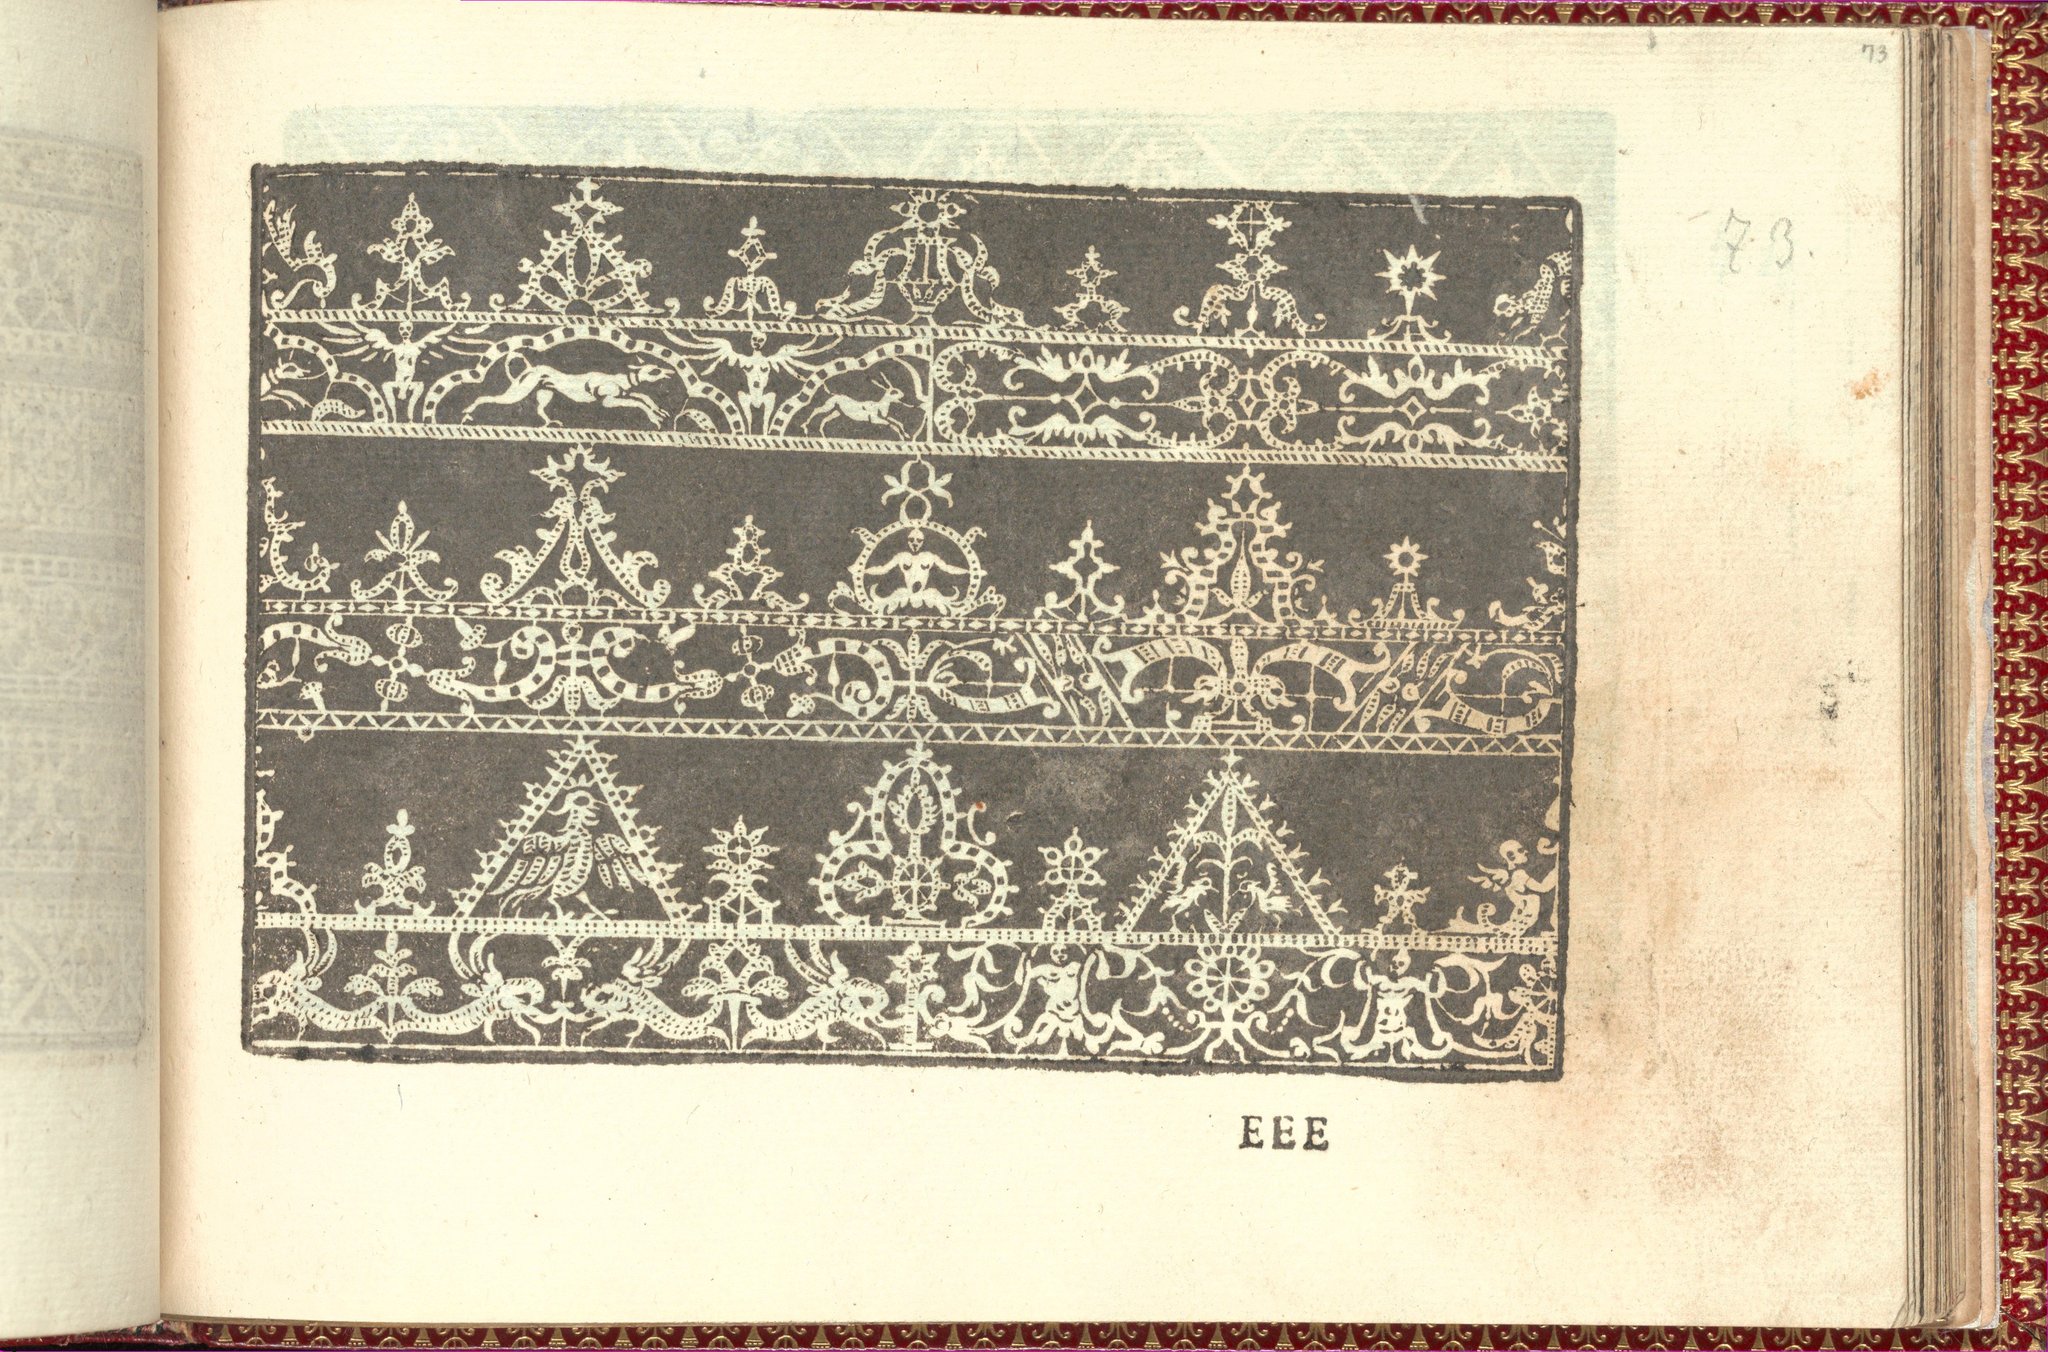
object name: book print ornament architecture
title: Corona delle Nobili et Virtuose Donne: Libro I-IV, page 73 (recto)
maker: cesare vecellio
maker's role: publisher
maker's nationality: italian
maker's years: 1521-1601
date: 1601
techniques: woodcut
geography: italy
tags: ornament